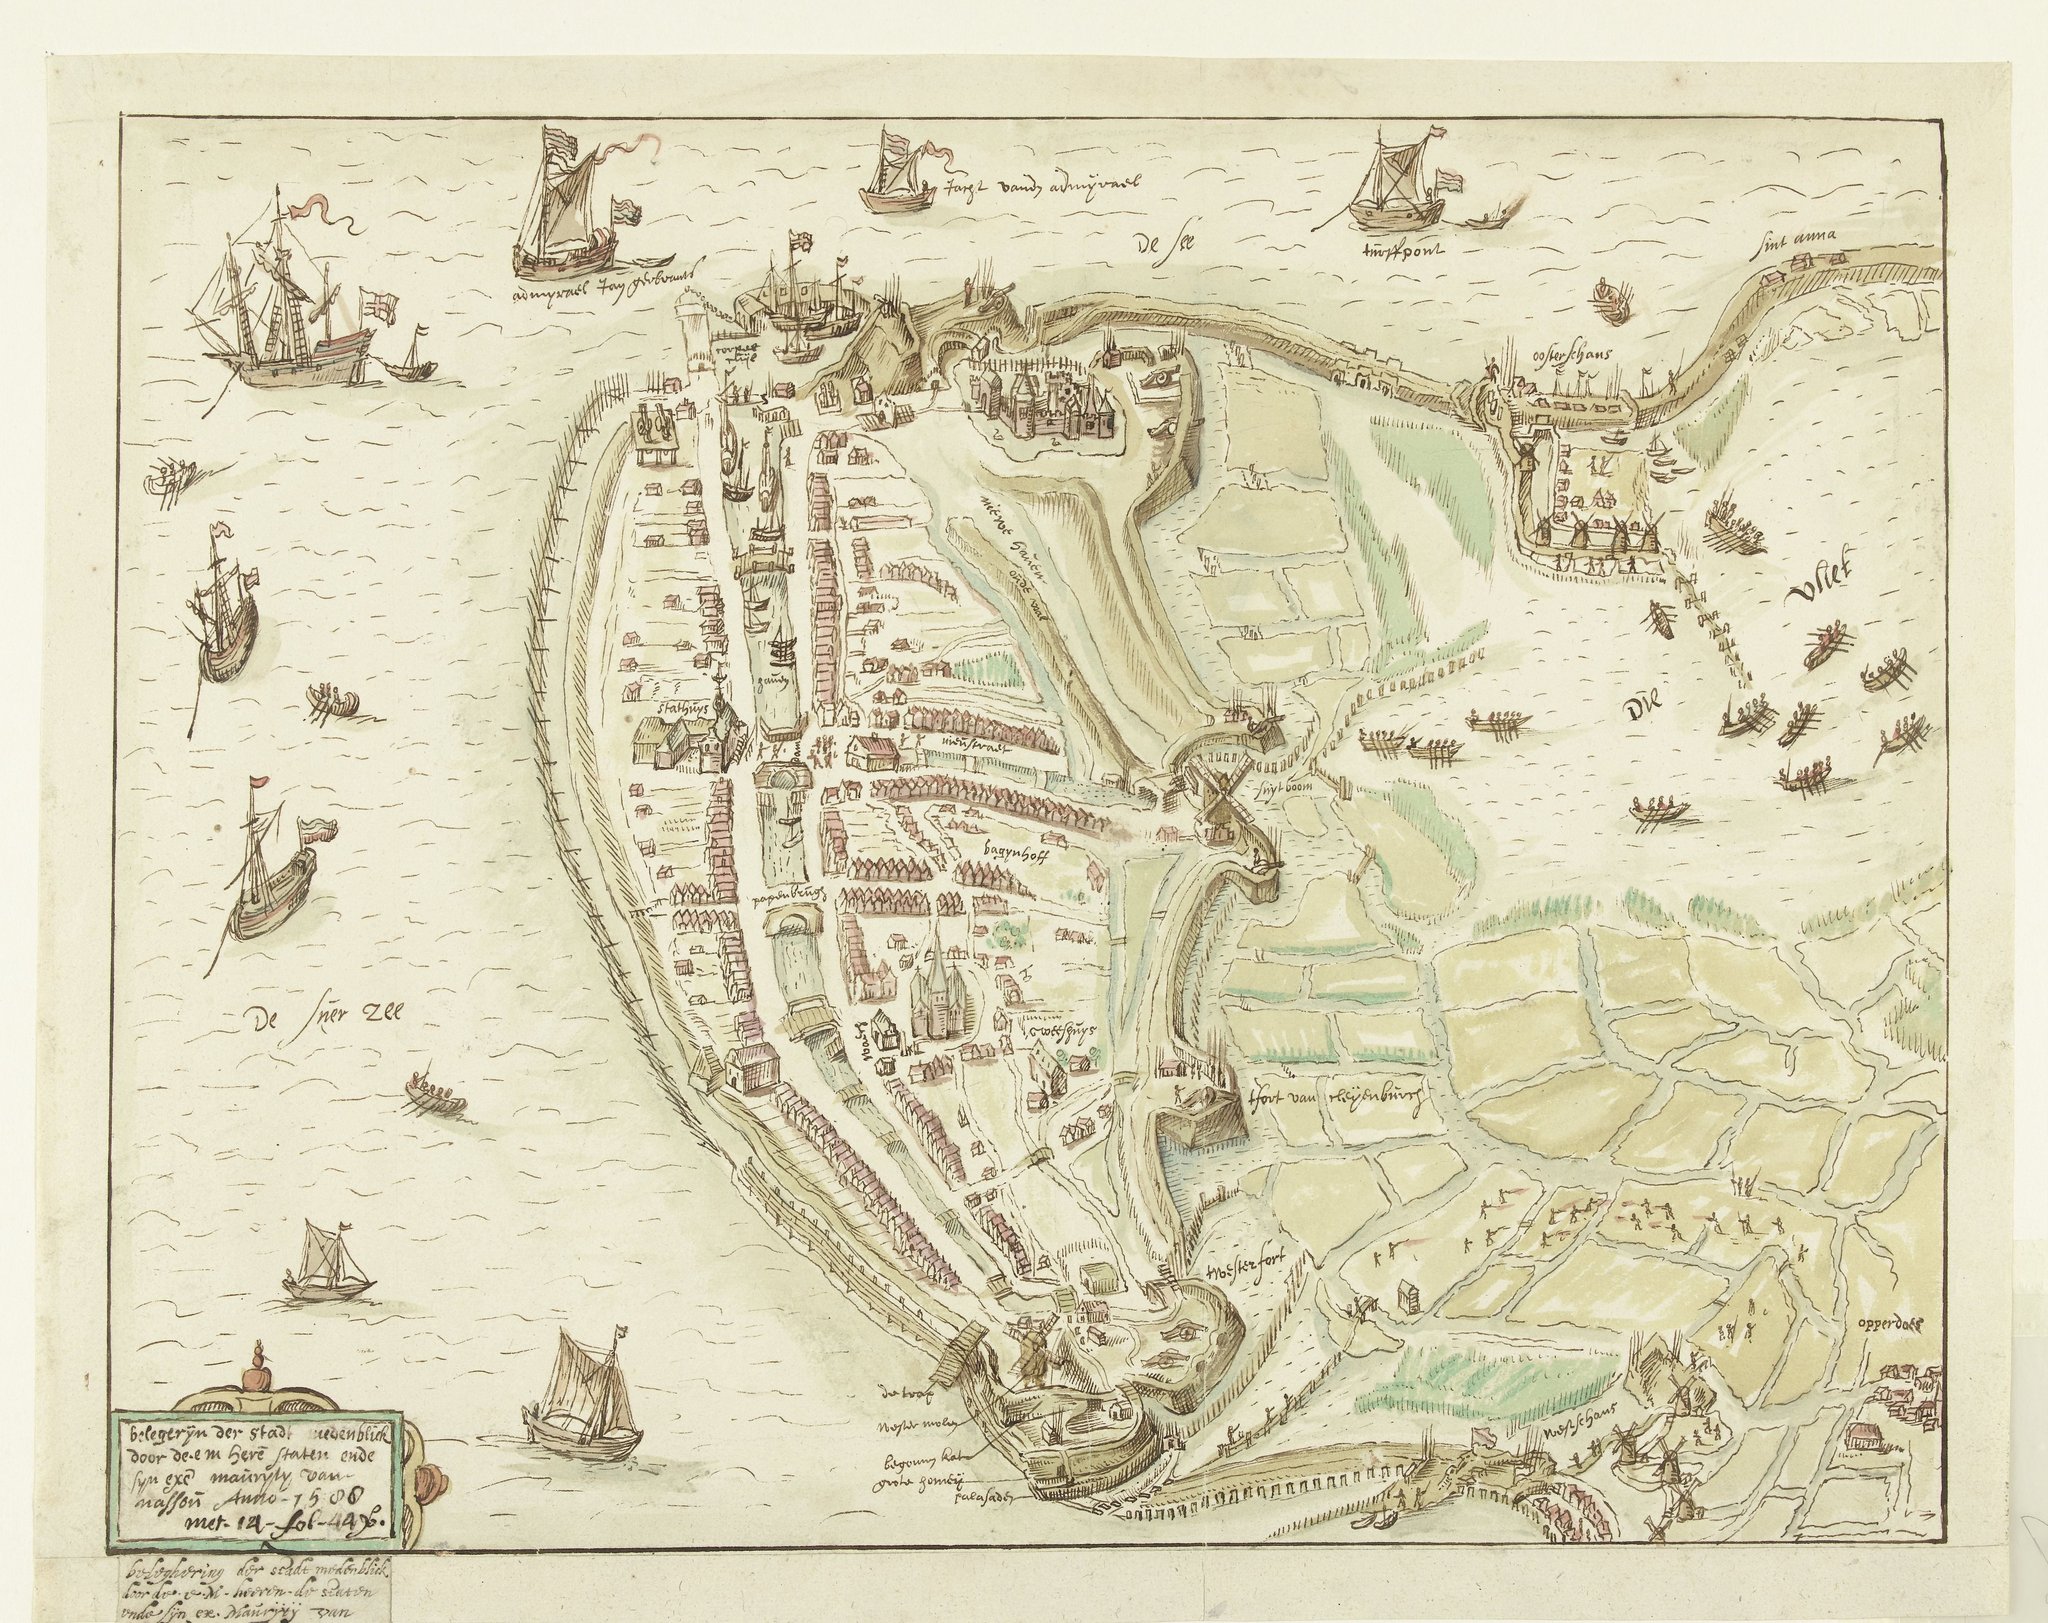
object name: drawing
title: Beleg van Medemblik, 1588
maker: Anonymous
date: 1588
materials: paper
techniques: brush, pen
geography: northern netherlands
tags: maurice (prince of orange), siege, position war, maps of cities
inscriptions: date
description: Belegering van de stad Medemblik door het leger van Maurits van februari tot eind april 1588. Gedetailleerde kaart van de stad met omringend land. Rechtsonder Opperdoes, links de Zuiderzee met het schip van admiraal Jan Gerbrandts. Linksonder een kleine cartouche met de titel, hieroverheen was een stuk papier met een tweede, identieke titel geplakt.